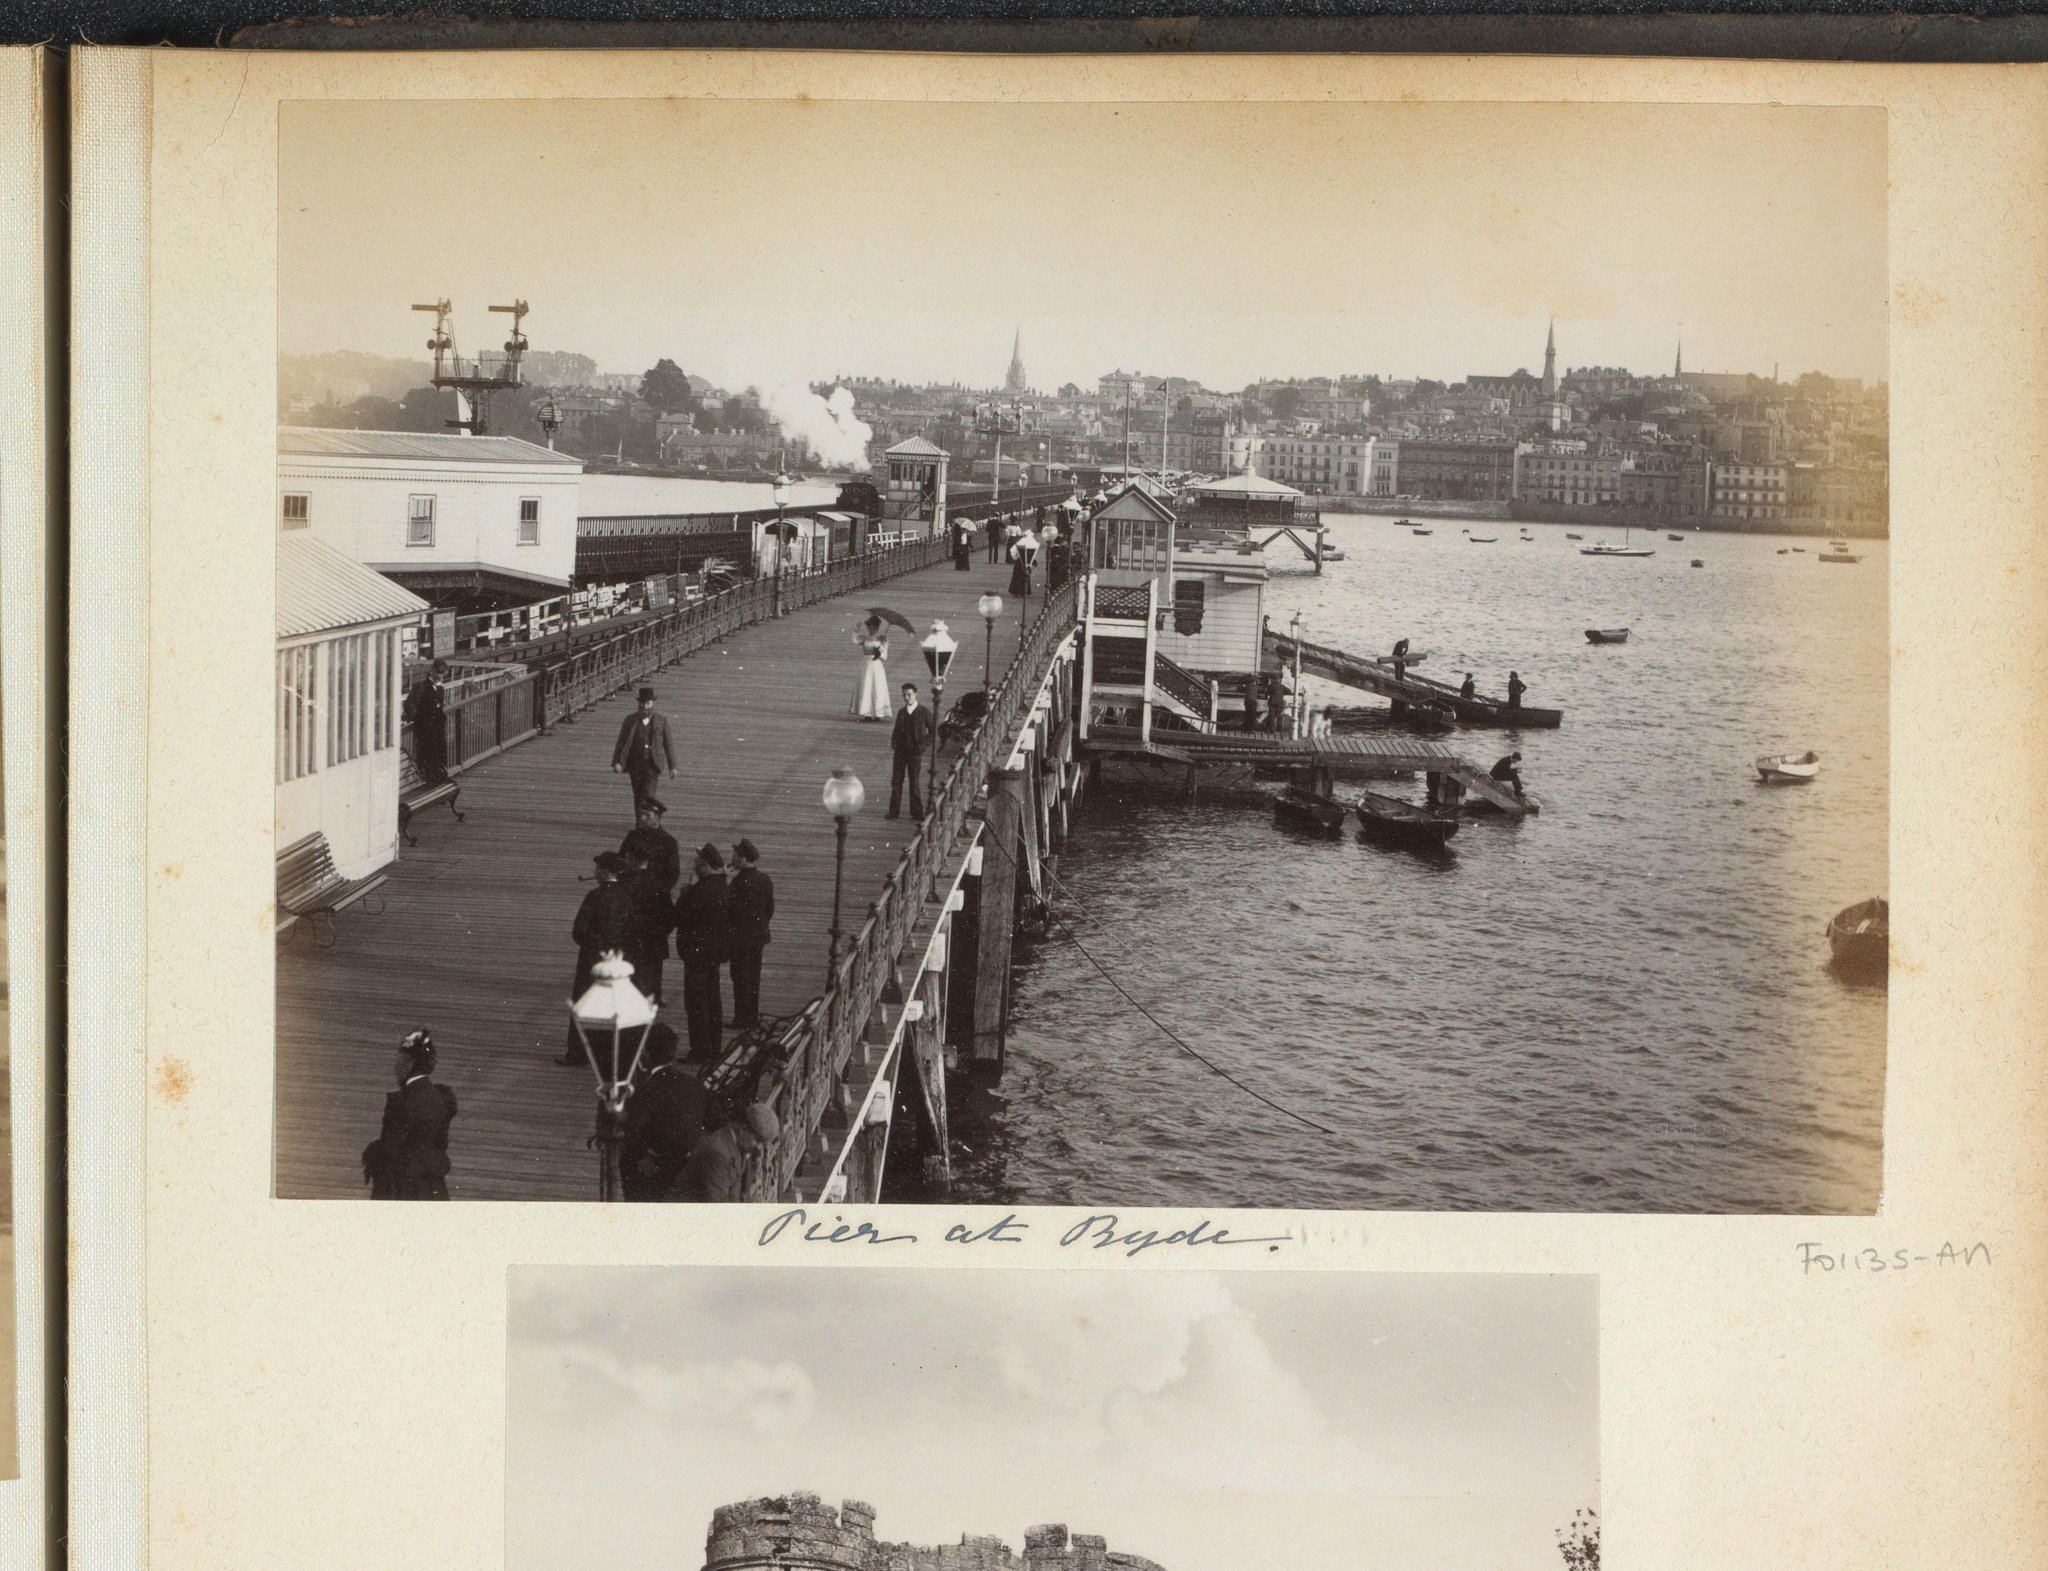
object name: photograph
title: Wandelaars op de Ryde Pier, op de achtergrond de stad Ryde op het Isle of Wight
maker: frederick nutt broderick jr.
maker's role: fotograaf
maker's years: 1854-1913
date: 1898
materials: paper, photographic support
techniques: albumen print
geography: ryde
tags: strolling, pier, quay, wharf, prospect of city, town panorama, silhouette of city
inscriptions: check stamp: ‘Broderick's series’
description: Onderdeel van Reisalbum met foto's van bezienswaardigheden in Engeland en Frankrijk.